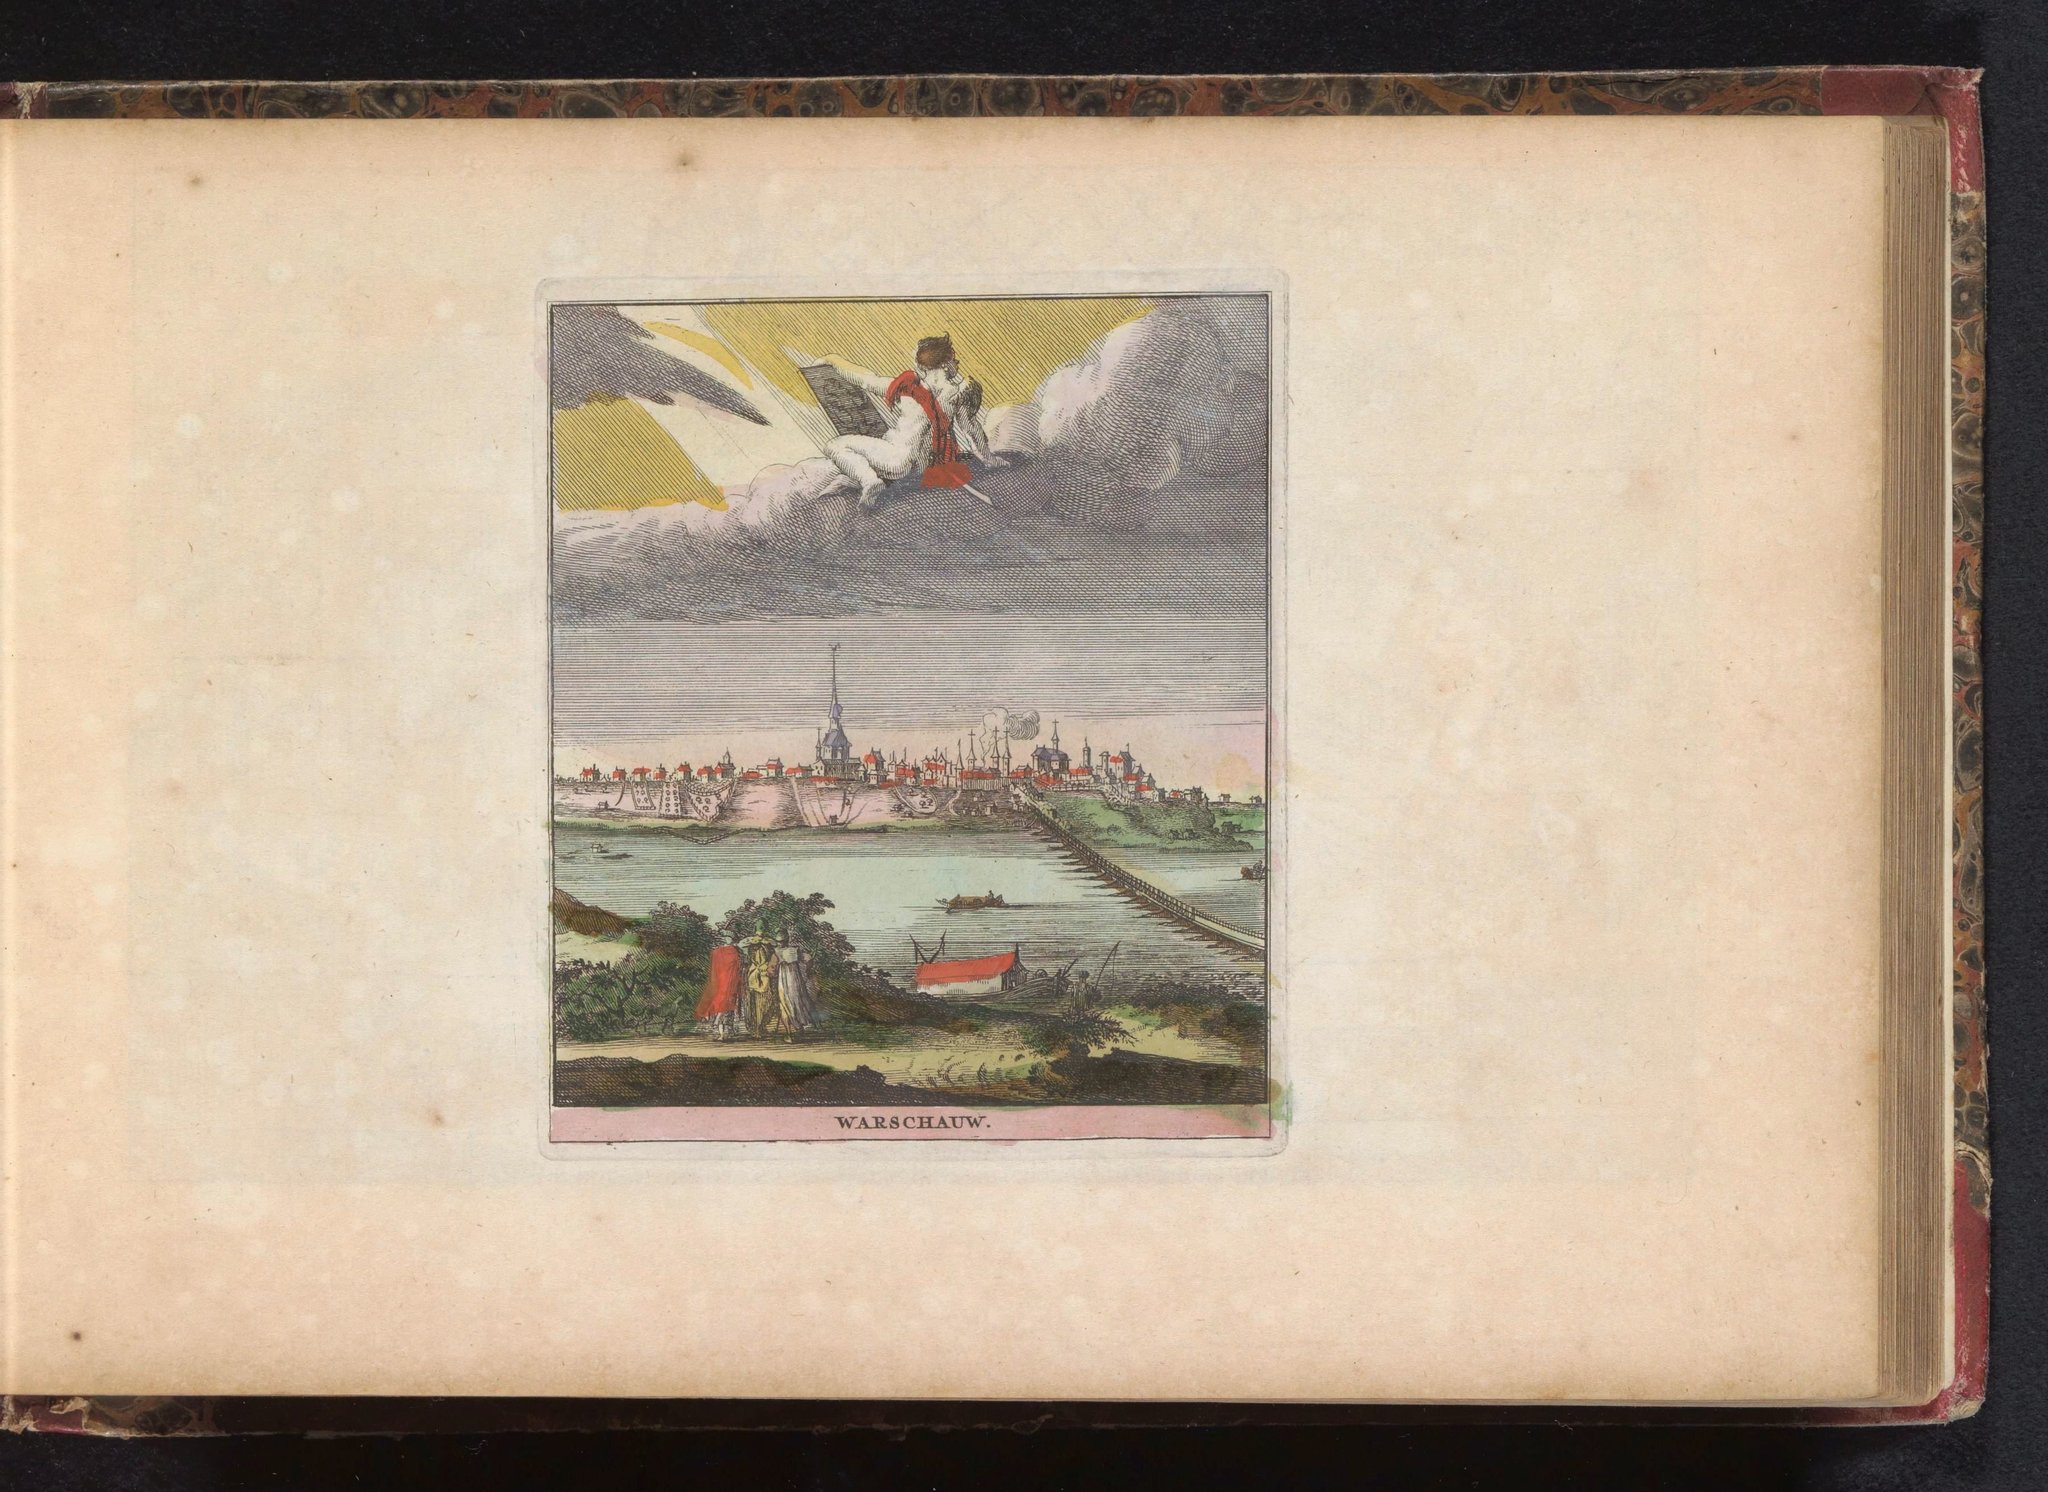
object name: print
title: Gezicht op Warschau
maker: Anonymous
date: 1735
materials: paper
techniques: engraving, etching, hand coloring, lacquer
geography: northern netherlands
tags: maps of cities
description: Gezicht op de Poolse stad Warschau. In de wolken een engel met een bord waarop een wapen met een leeuw. Onderdeel van een atlas met 223 kaarten van landen en steden en oorlogstaferelen in Europa in de periode ca. 1690-1735.